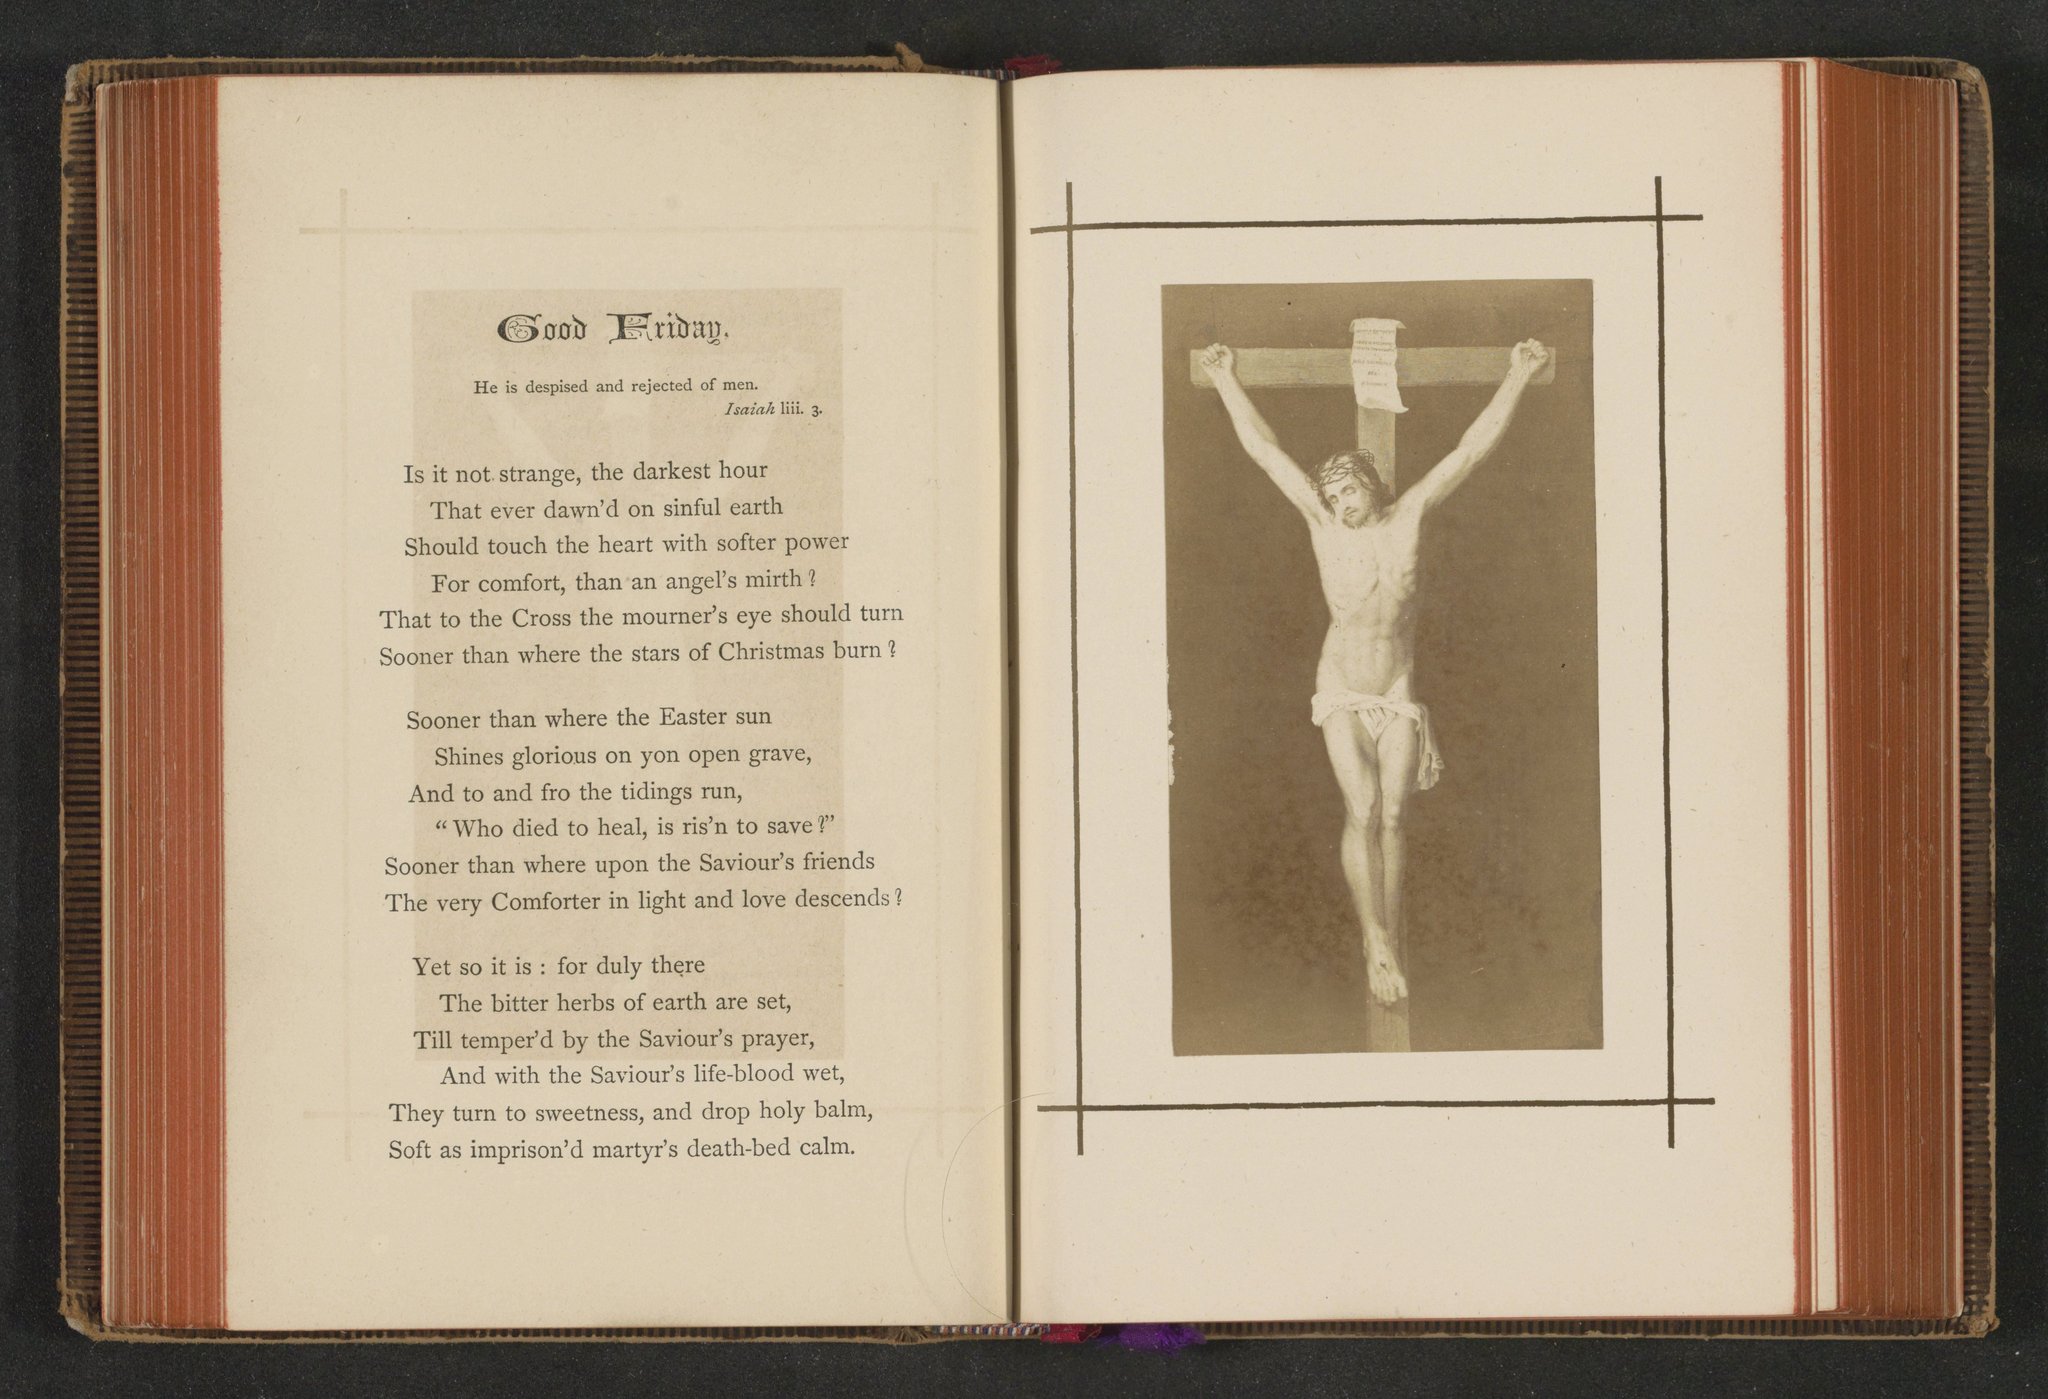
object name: page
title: Fotoreproductie van een prent, voorstellende de kruisiging van Christus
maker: Anonymous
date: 1865-1870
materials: photographic support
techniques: albumen print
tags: the crucifixion of christ: christ's death on the cross; golgotha (matthew 27:45-58; mark 15:33-45; luke 23:44-52; john 19:25-38)